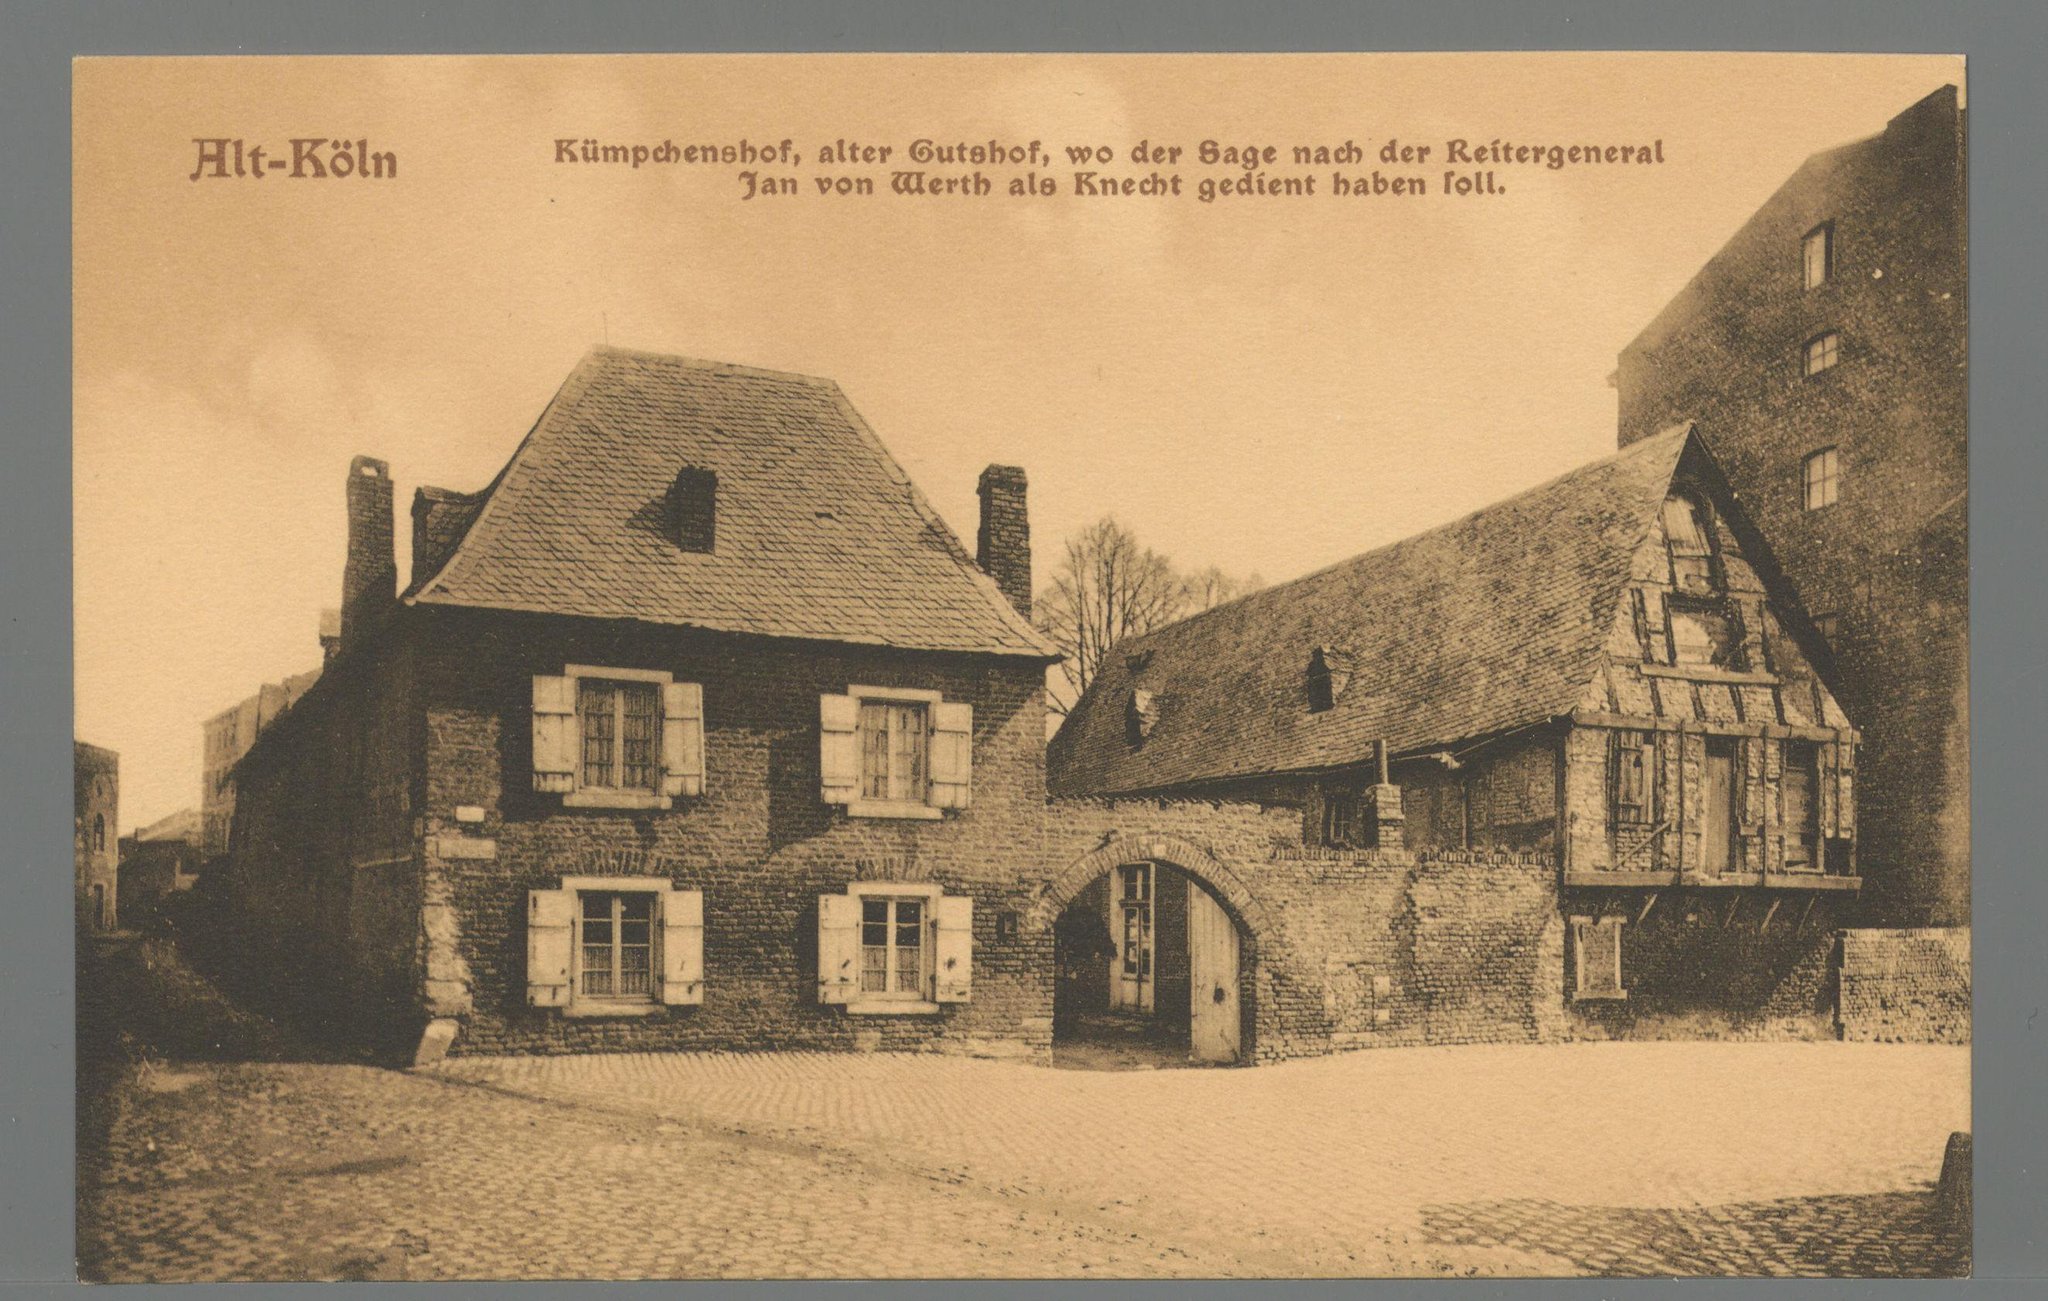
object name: photomechanical print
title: Alt-Köln. Kümpchenshof, alter Gutshof, wo der Sage nach der Reitergeneral Jan von Werth als Knecht gedient haben zoll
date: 1905-1920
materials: cardboard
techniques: photograph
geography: cologne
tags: street, cologne